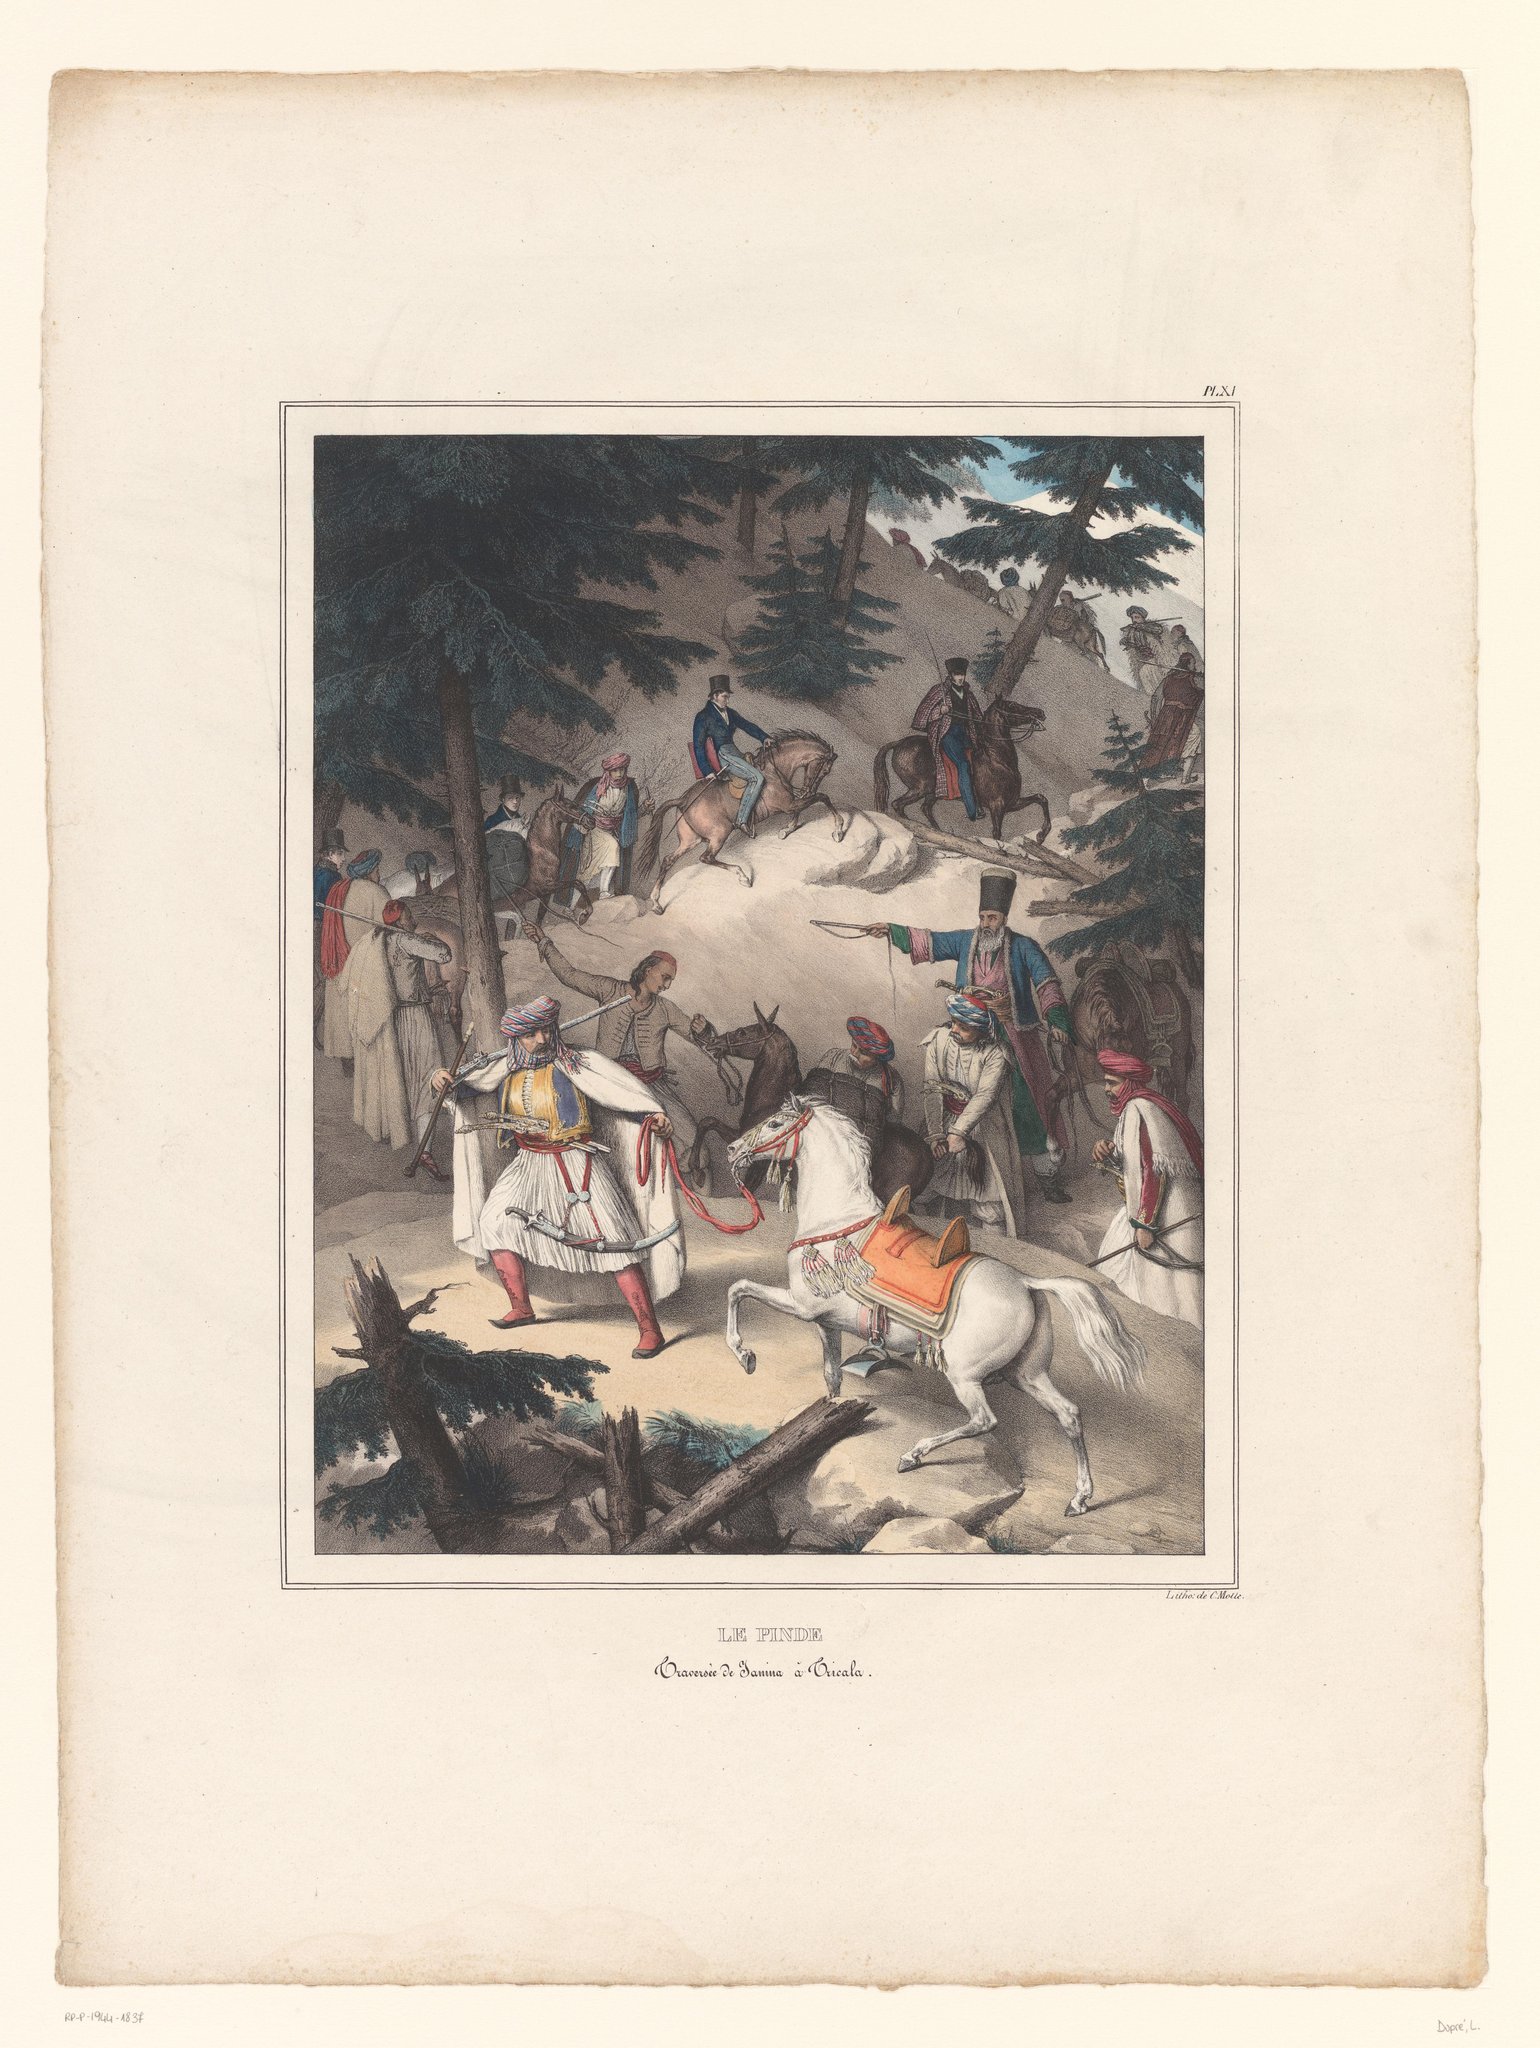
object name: print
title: Reis naar Athene en Constantinopel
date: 1825-1837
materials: paper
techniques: hand coloring, lithograph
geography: paris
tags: leading a horse by the reins; rider beside his horse, 'en route', traveller under way, mountains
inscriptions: check stamp: ‘LD’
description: De prent maakt deel uit van de serie 'Voyage à Athènes et à Constantinople ou collection de portraits, de vues et de costumes Grecs et Ottomans' die tussen 1825 en 1839 in tien delen van vier prenten werd uitgebracht. De in totaal veertig prenten dienden samen met een tekst van 52 pagina's voorzien van vignettes als een verslag van de reis die Louis Dupré in 1819 naar Athene en het huidige Istanboel maakte (zie documentatie).